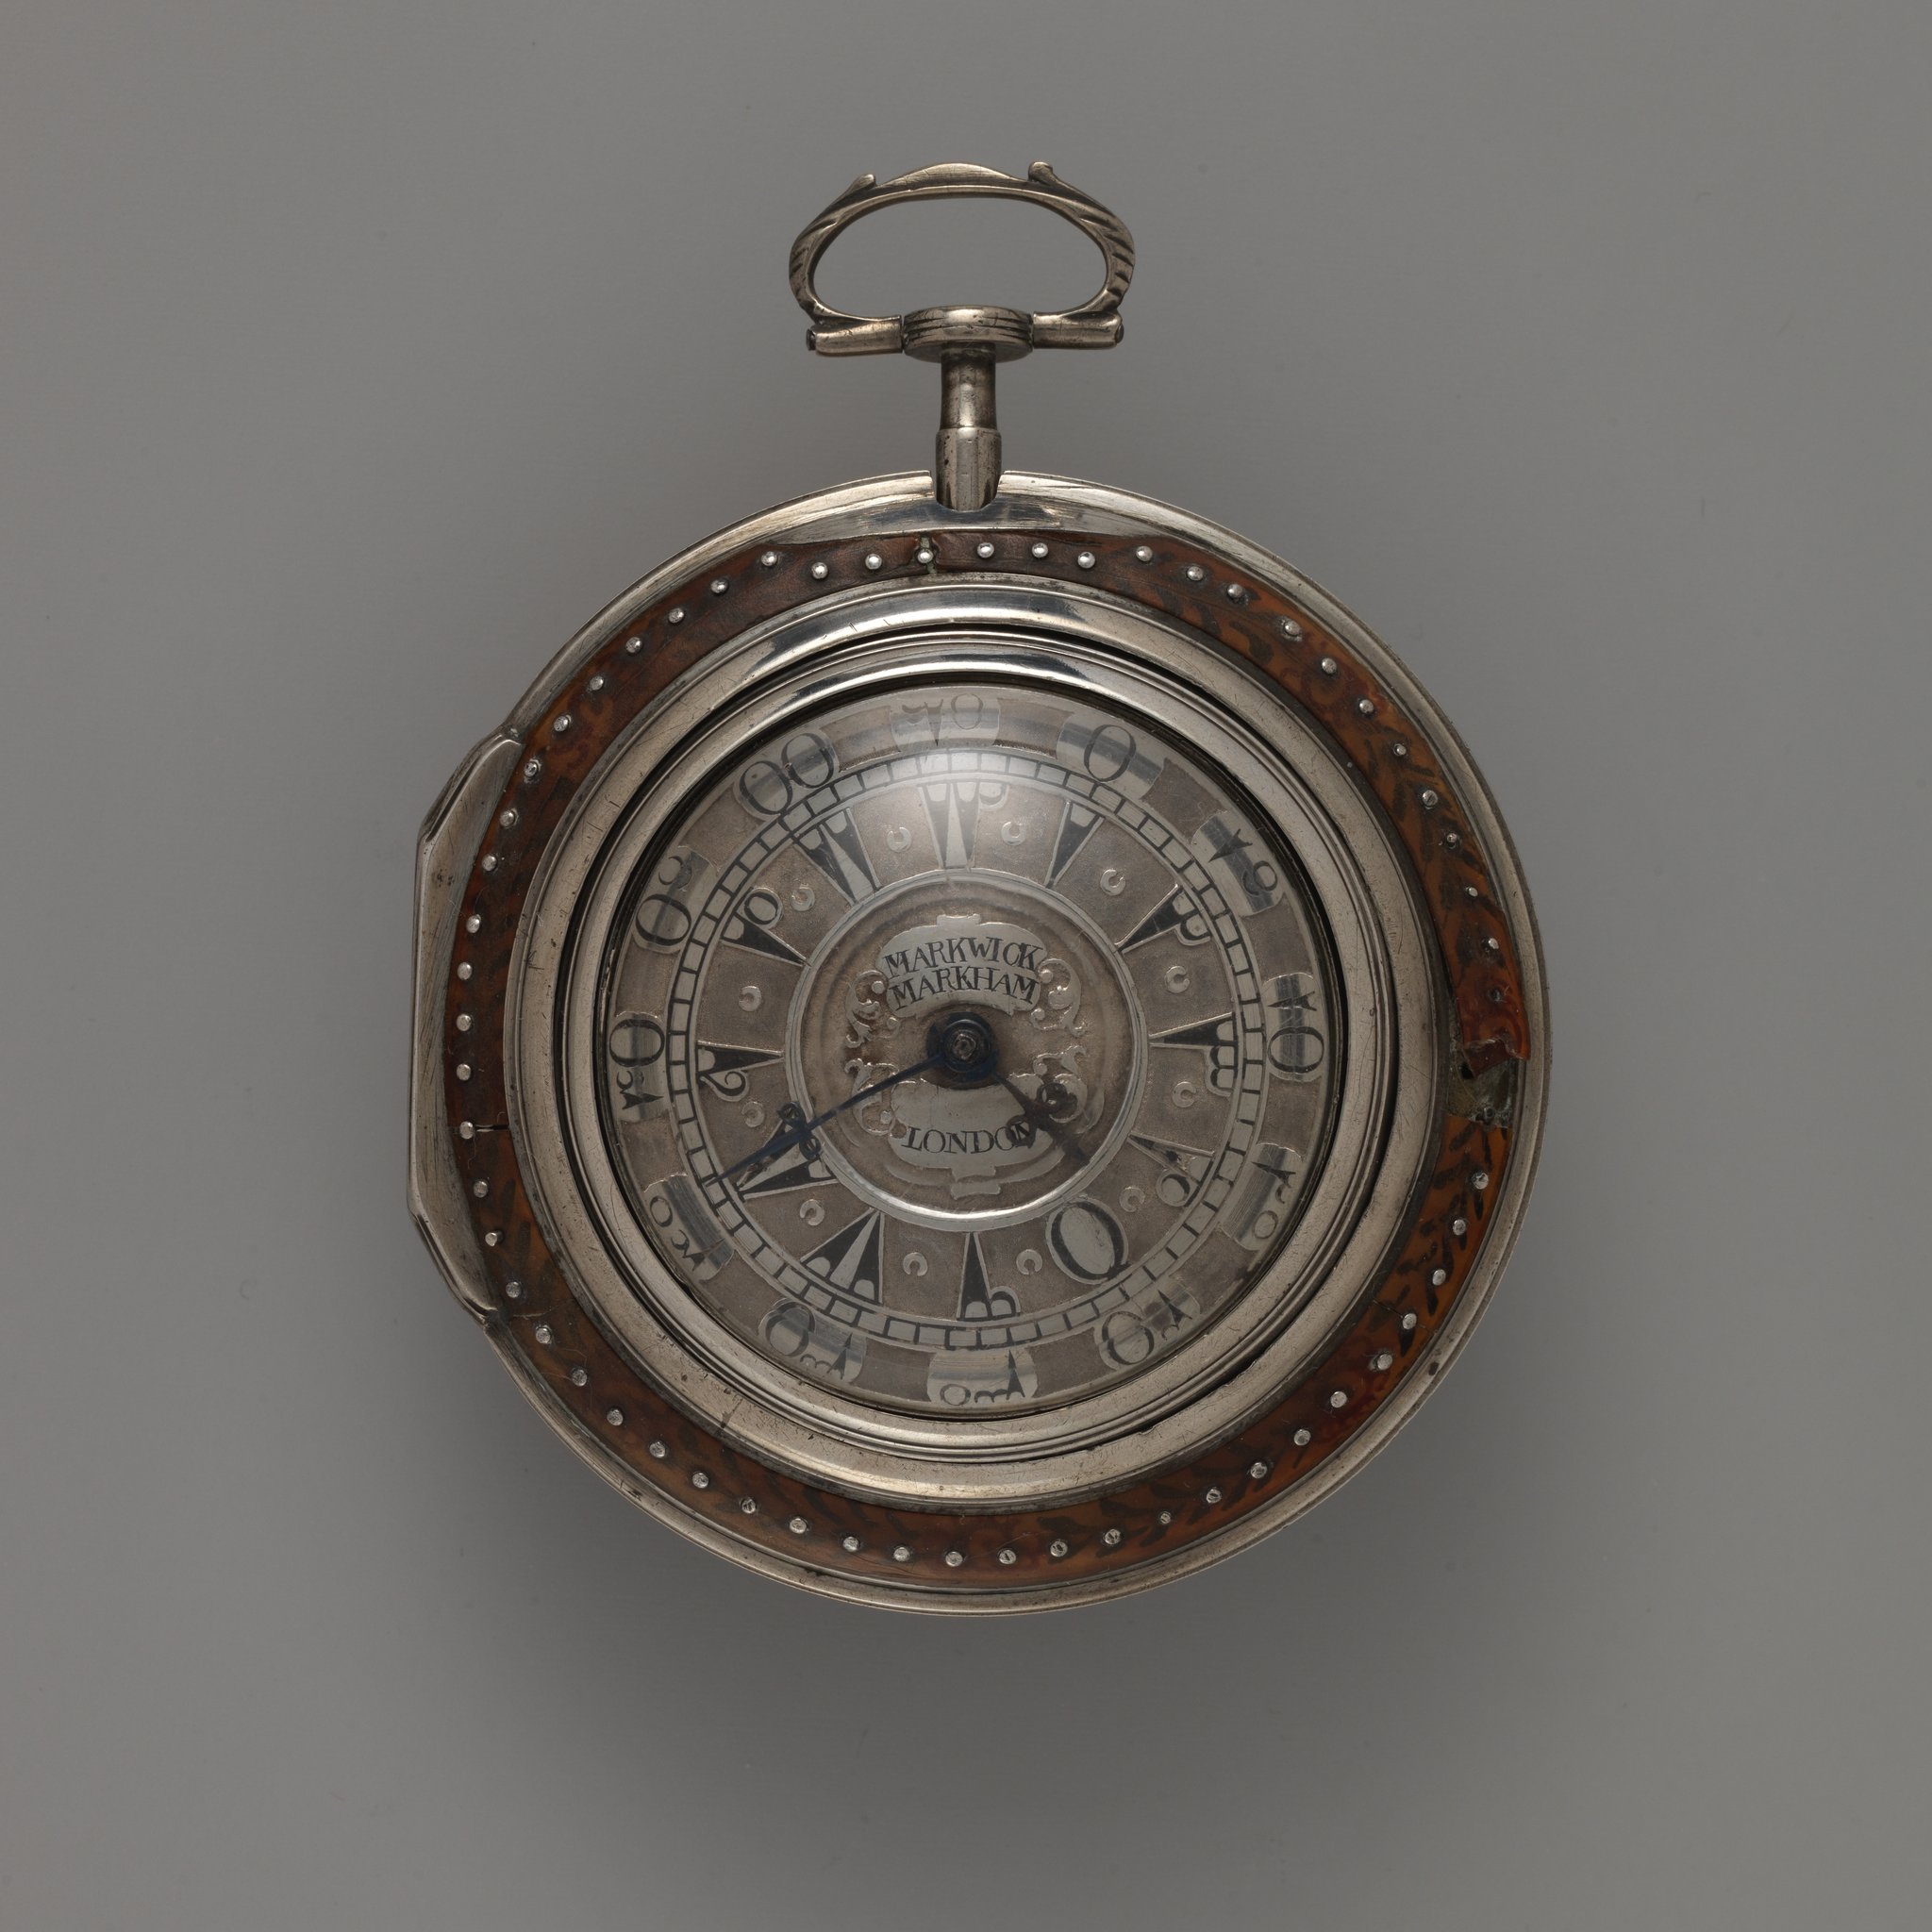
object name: watch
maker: firm of markham, marwick et marko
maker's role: maker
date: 1801-1833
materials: horn, silver